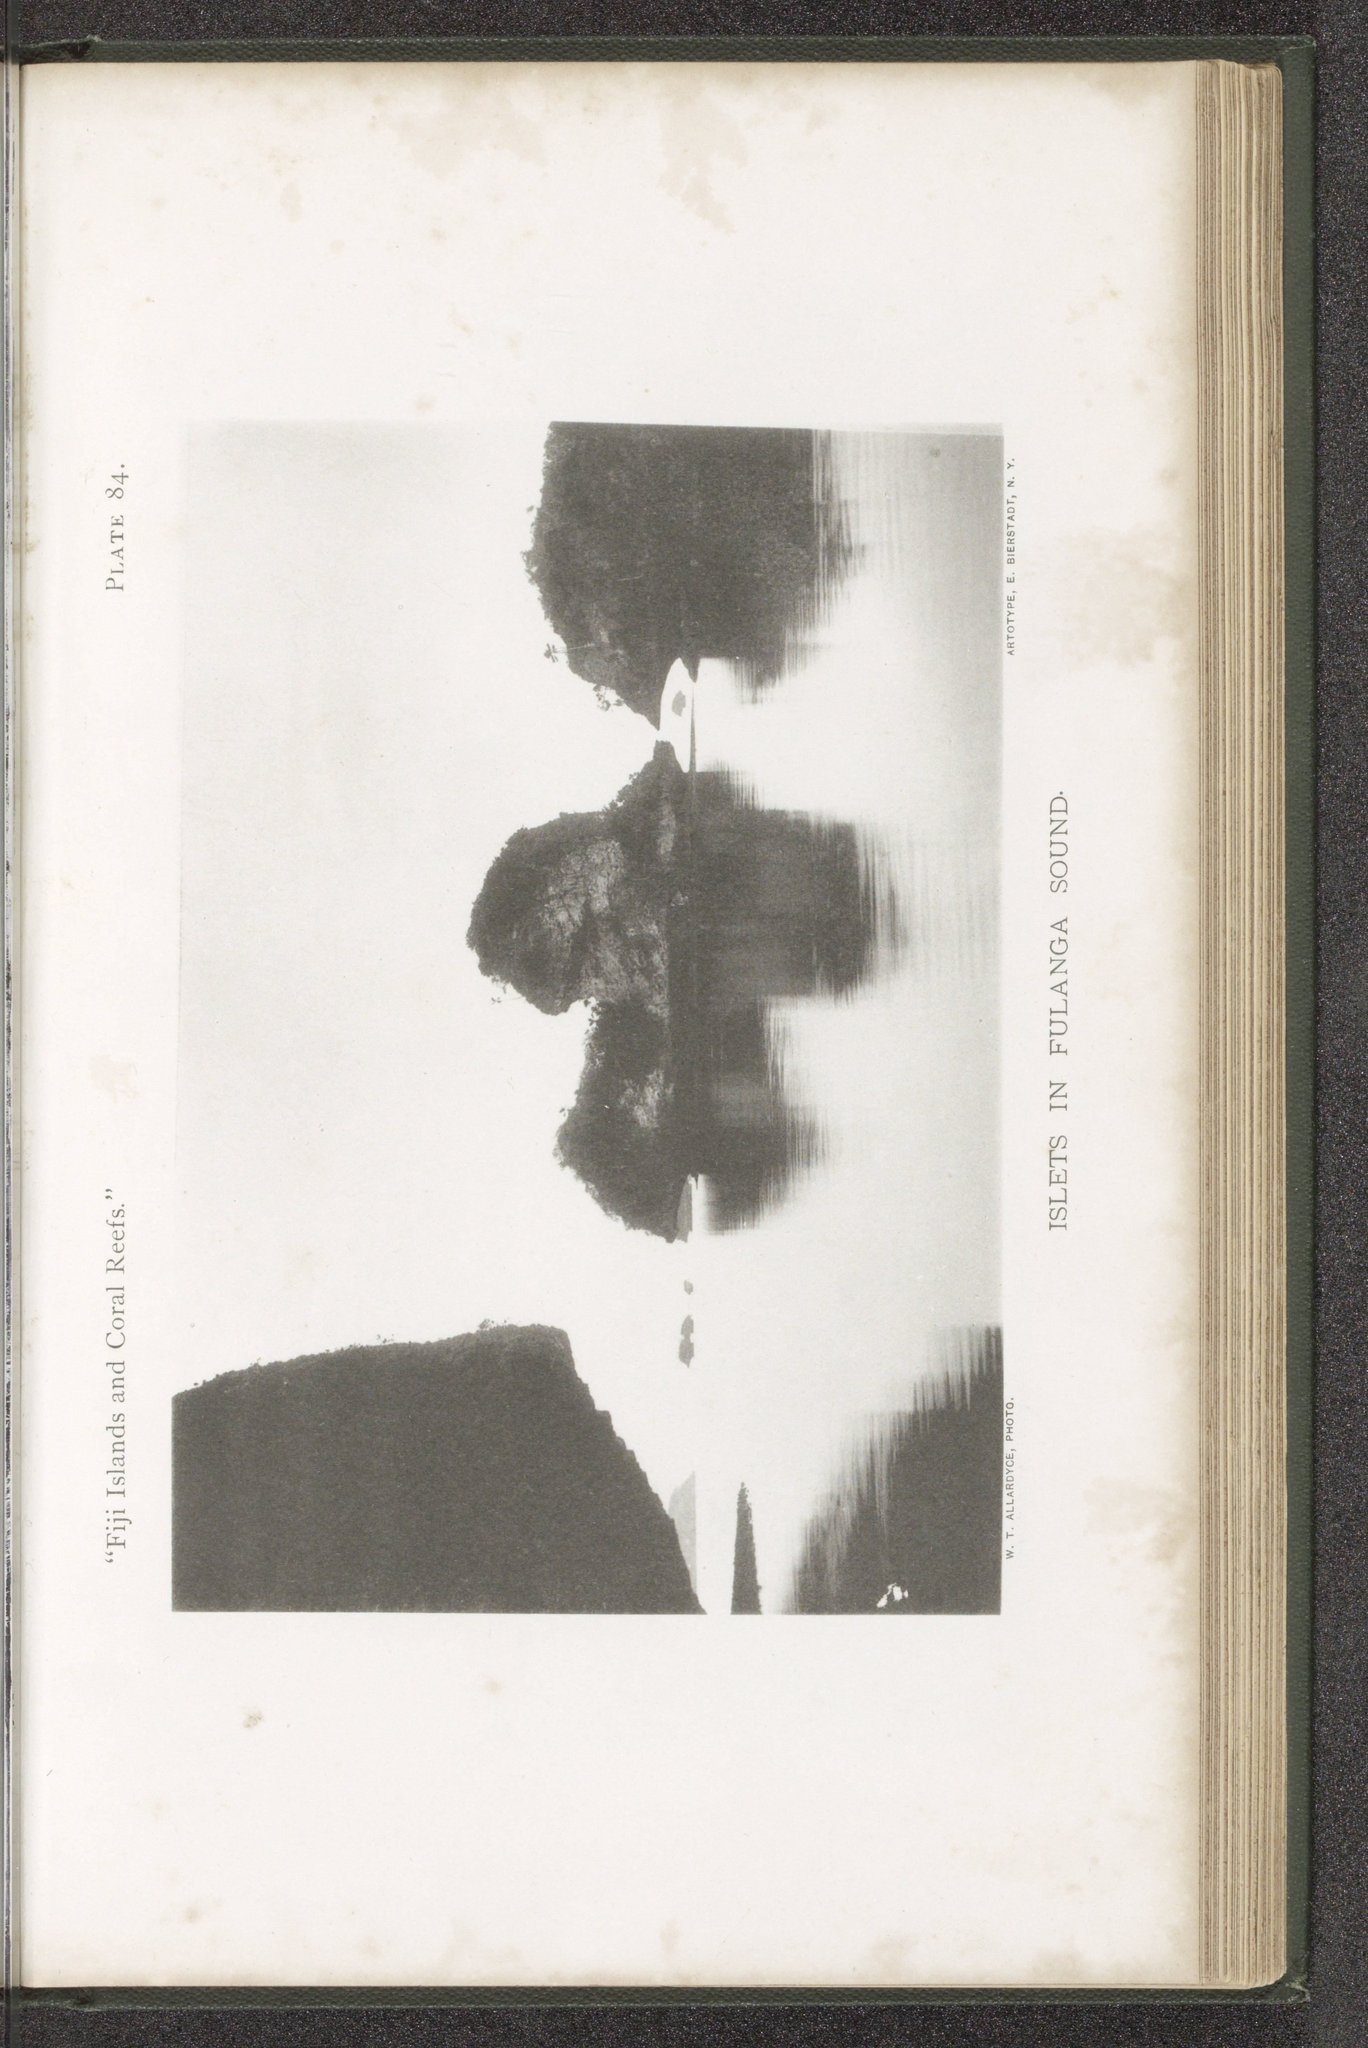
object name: page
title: Islets in Fulanga sound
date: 1879-1899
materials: paper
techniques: photograph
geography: fiji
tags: island, ocean, haff, lagoon created by sand, shingle bank ~ coast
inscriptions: name: ‘Artotype, E. Bierstadt, N. Y.’, name: ‘W.T. Allardyce, Photo.’, number: ‘Plate 84.’